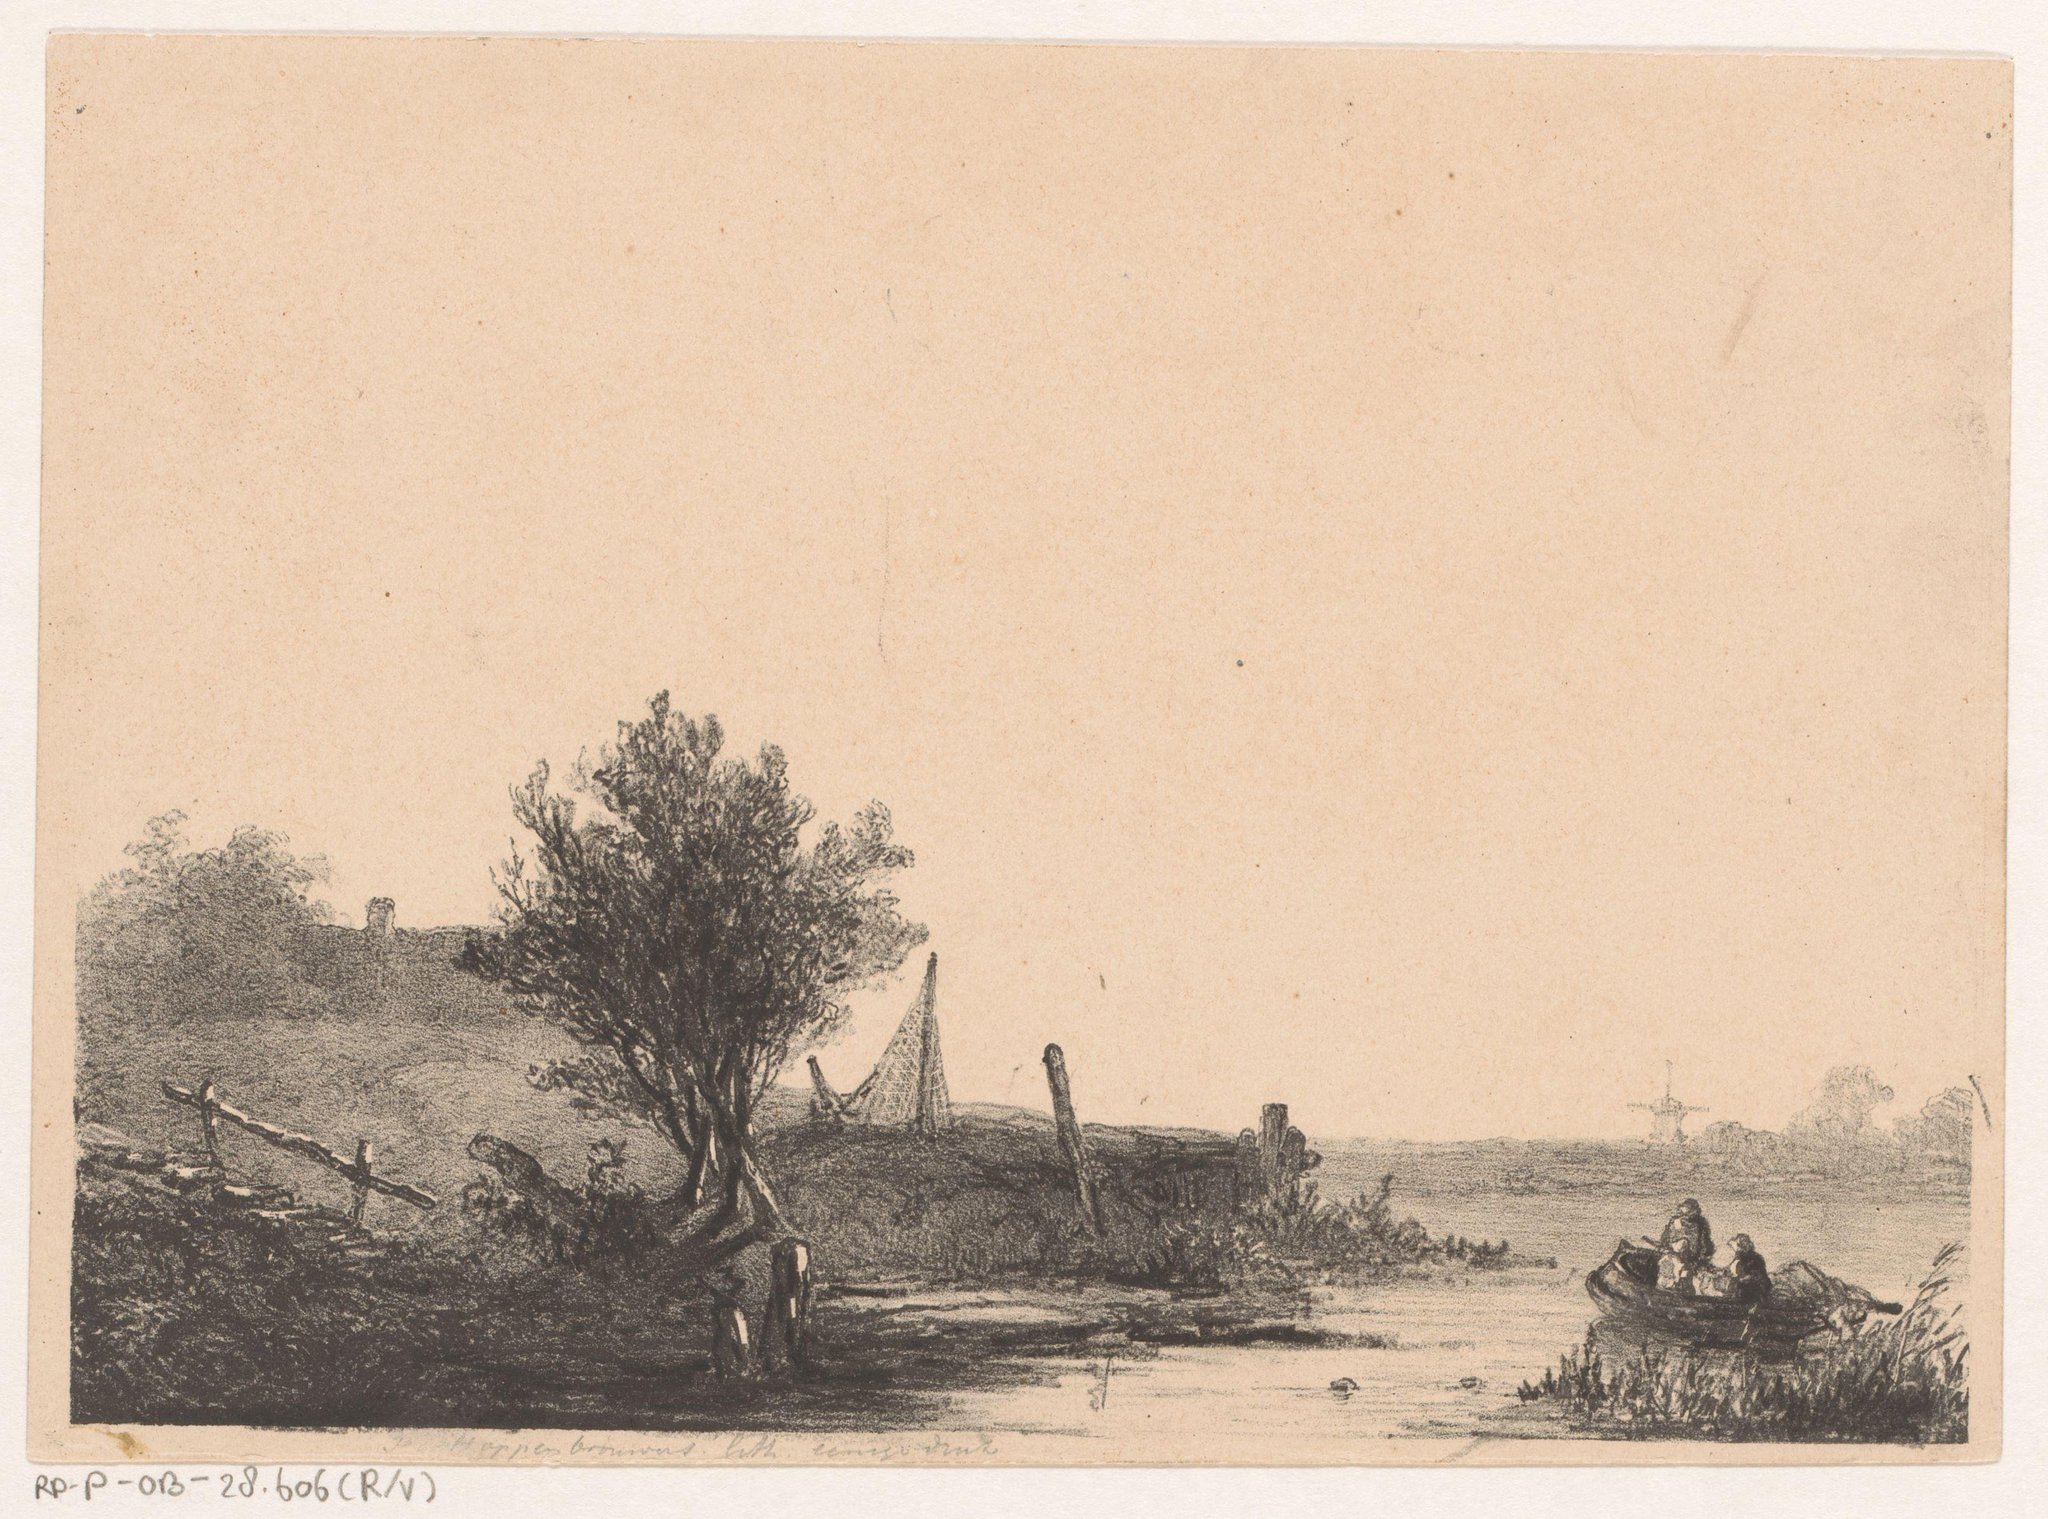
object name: print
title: Rivierlandschap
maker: johannes franciscus hoppenbrouwers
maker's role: draughtsman, painter, print maker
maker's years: 1819-1866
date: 1829-1866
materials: paper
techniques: lithograph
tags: fishing net, river bank, rowing-boat, canoe, etc., river (+ landscape with figures, staffage)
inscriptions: collector's mark: Lugt 2228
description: Op het water vaart een roeiboot met drie figuren. Links op de oever is een huis zichtbaar achter de bomen. Er hangt een visnet aan een paal. Rechts aan de horizon een windmolen.